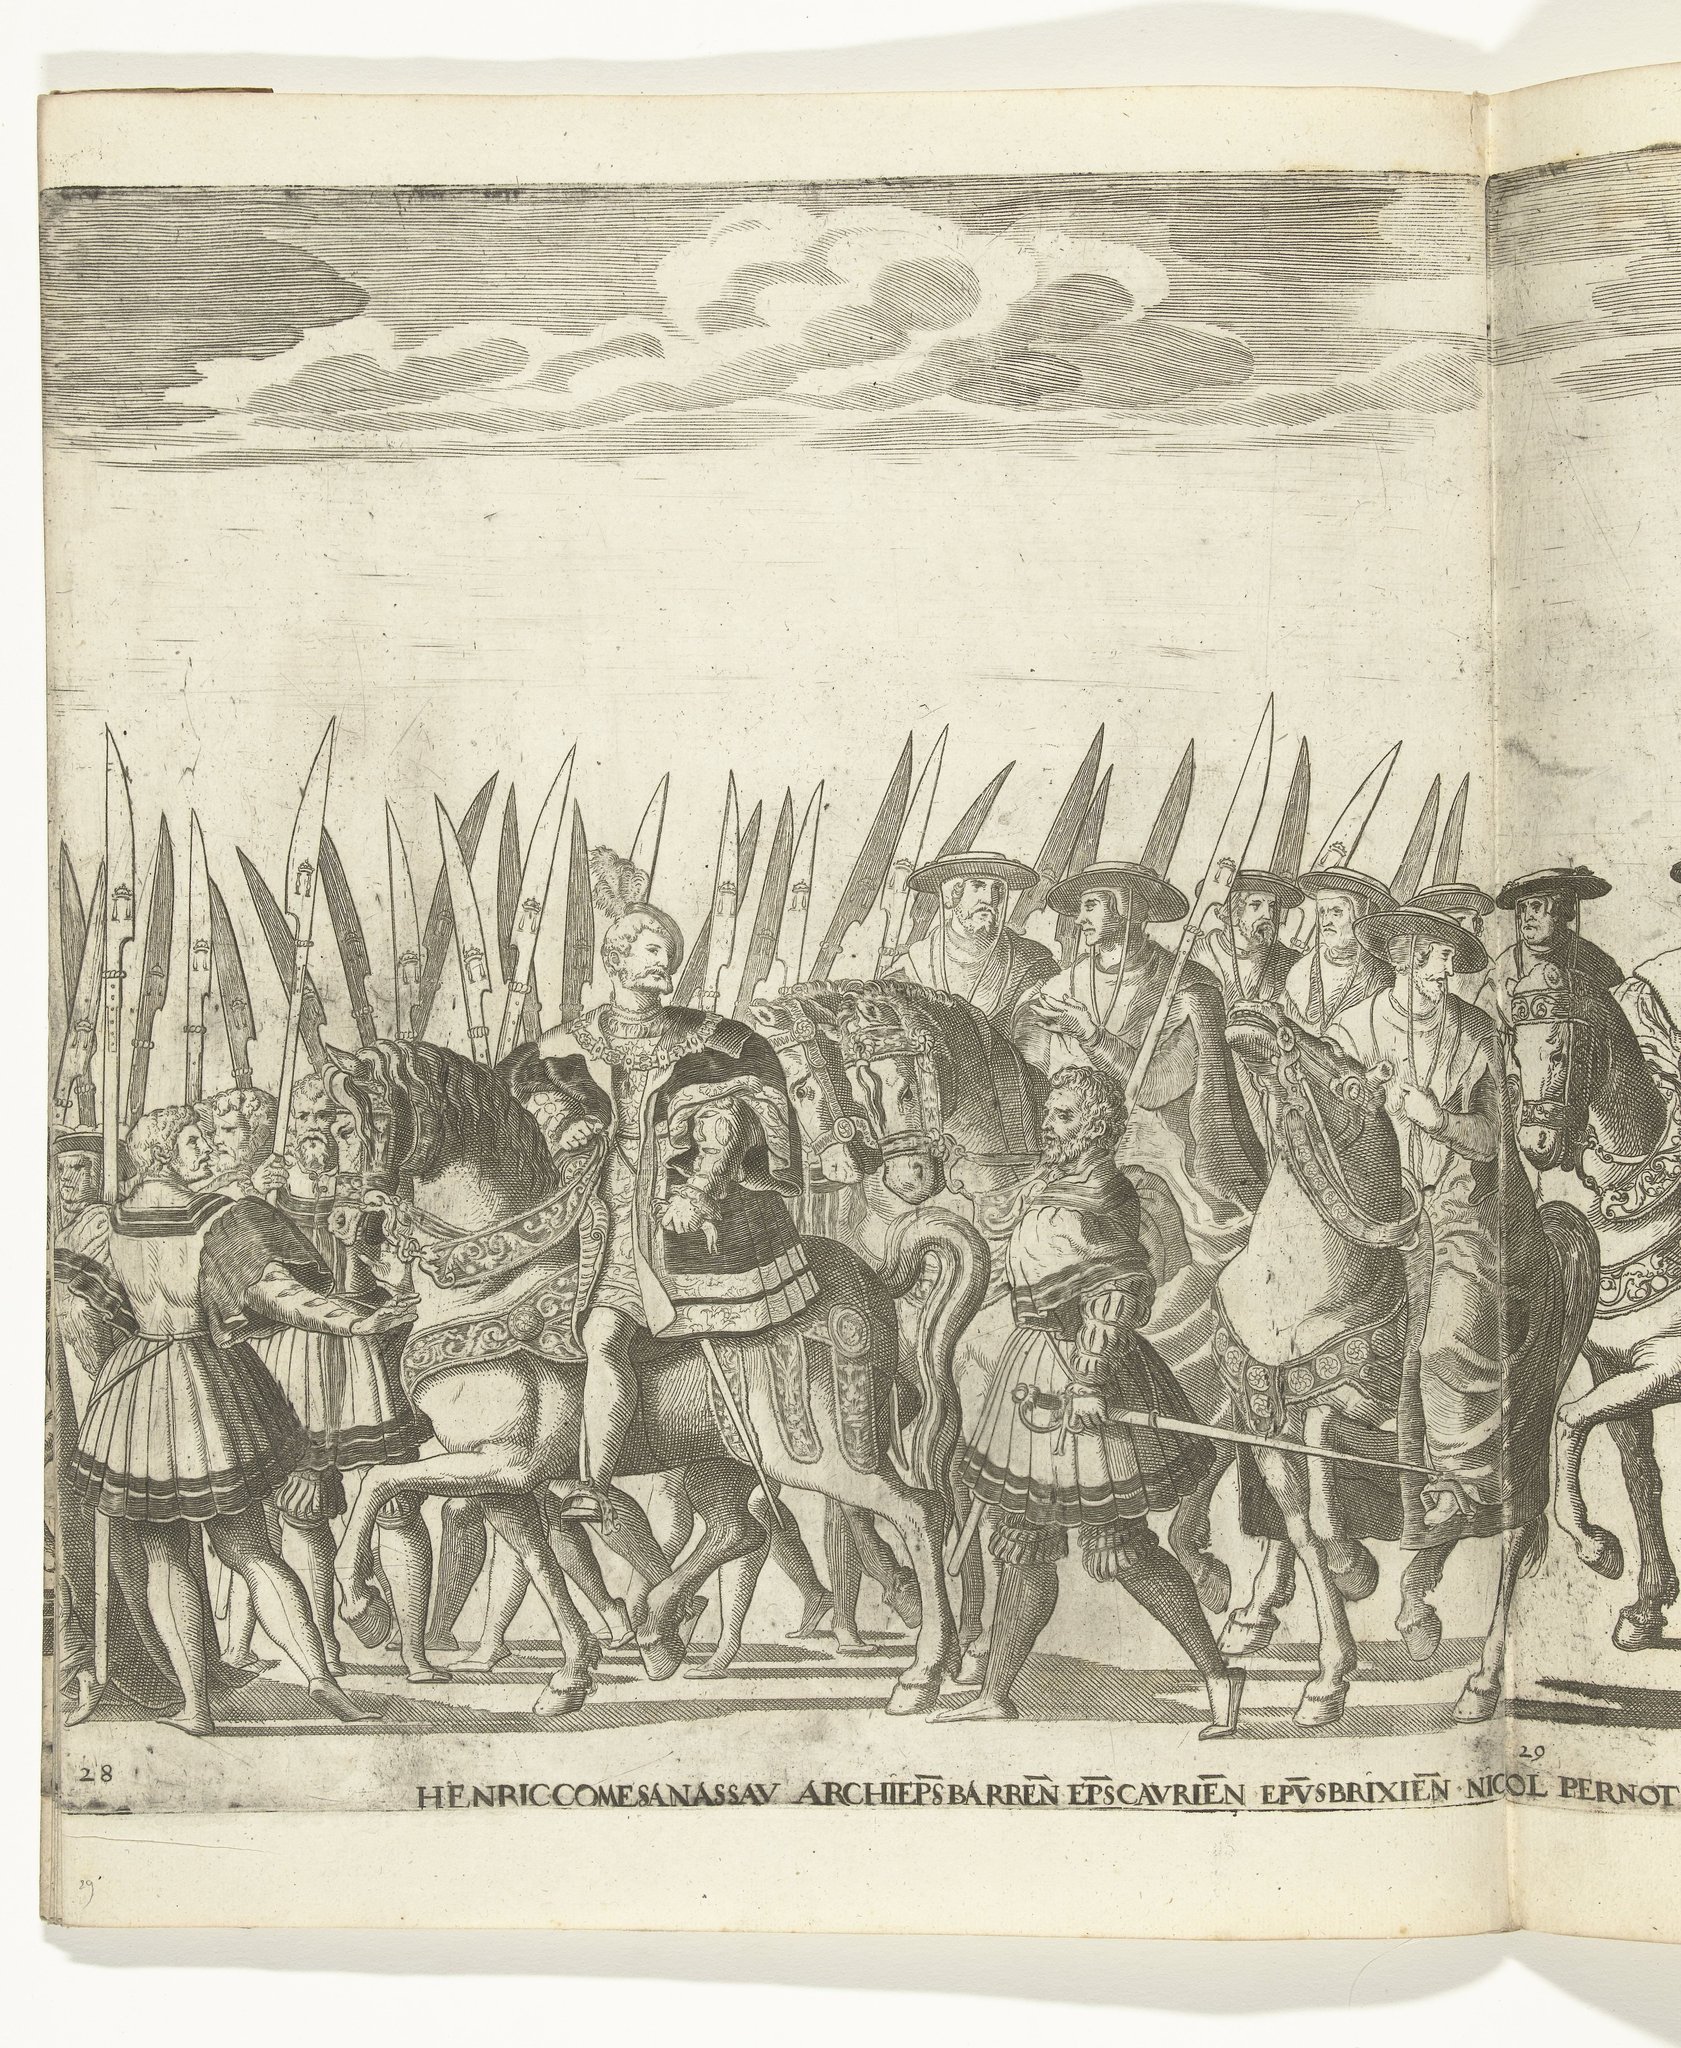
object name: print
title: Hendrik III van Nassau-Breda, plaat 28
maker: nicolaas hogenberg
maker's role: draughtsman, painter, print maker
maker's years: 1500-1539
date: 1530-1536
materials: paper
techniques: engraving, etching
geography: mechelen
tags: earl, charles v (holy roman emperor and king of spain), festivities (+ parade, pageant, cavalcade ~ festive activities)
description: In plaats van de geneologische afstamming van Karel V in het huis van Oostenrijk is in deze uitgave bovenin de platen een nieuw lucht gegraveerd. De platen zijn genummerd 1-38. Deze uitgave is later dan die van Hondius. De platen zijn aanelkaar geplakt en vormen zo één lang (opgevouwen) fries. Het opgevouwen fries ligt los in een map.